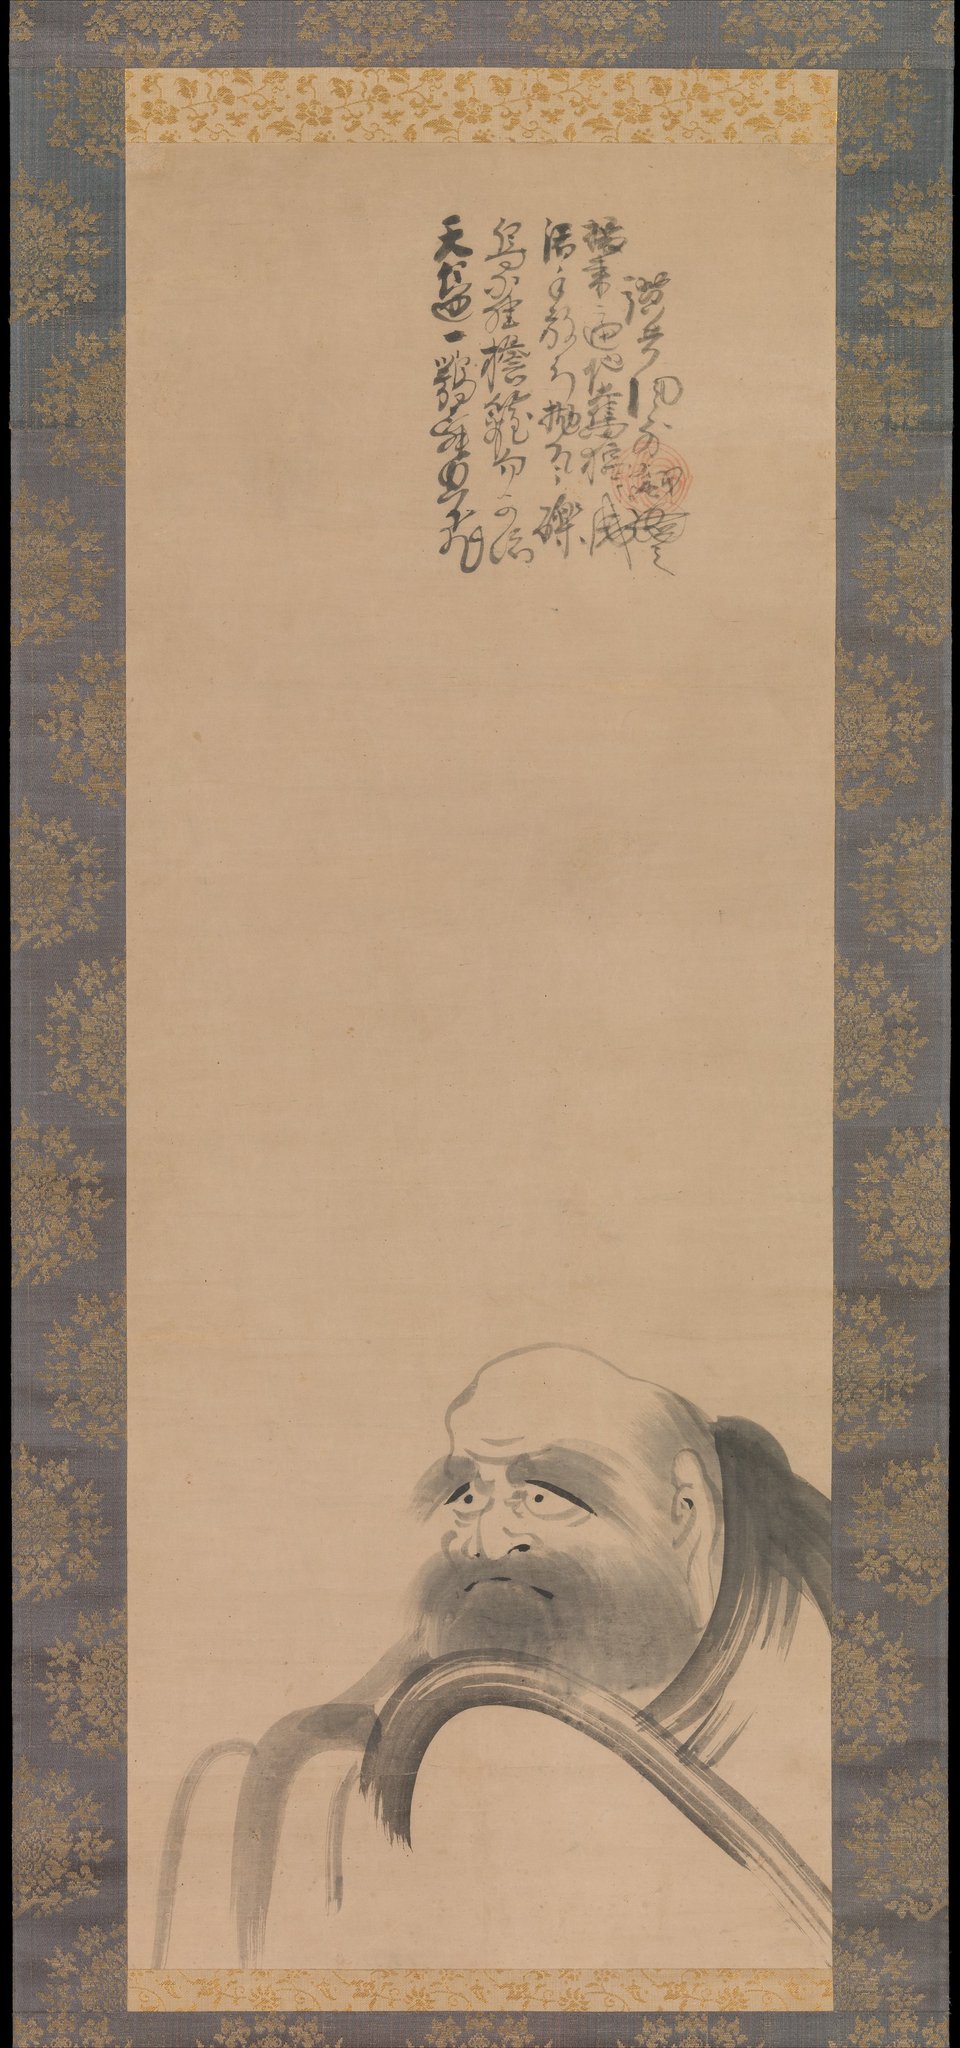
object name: hanging scroll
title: Portrait of Daruma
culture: japanese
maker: fūgai ekun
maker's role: artist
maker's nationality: japanese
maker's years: 1568-1654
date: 1601-1633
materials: ink, paper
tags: men,portraits,buddhism